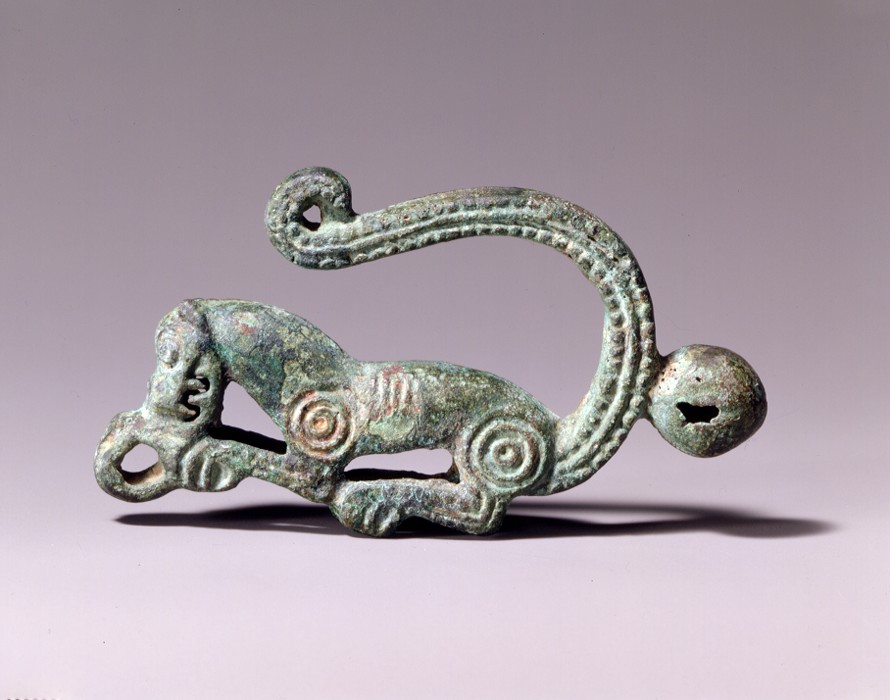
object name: harness ornament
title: Harness Ornament with a Crouching Tiger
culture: chinese, northeast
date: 700-501 BCE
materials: bronze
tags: tigers